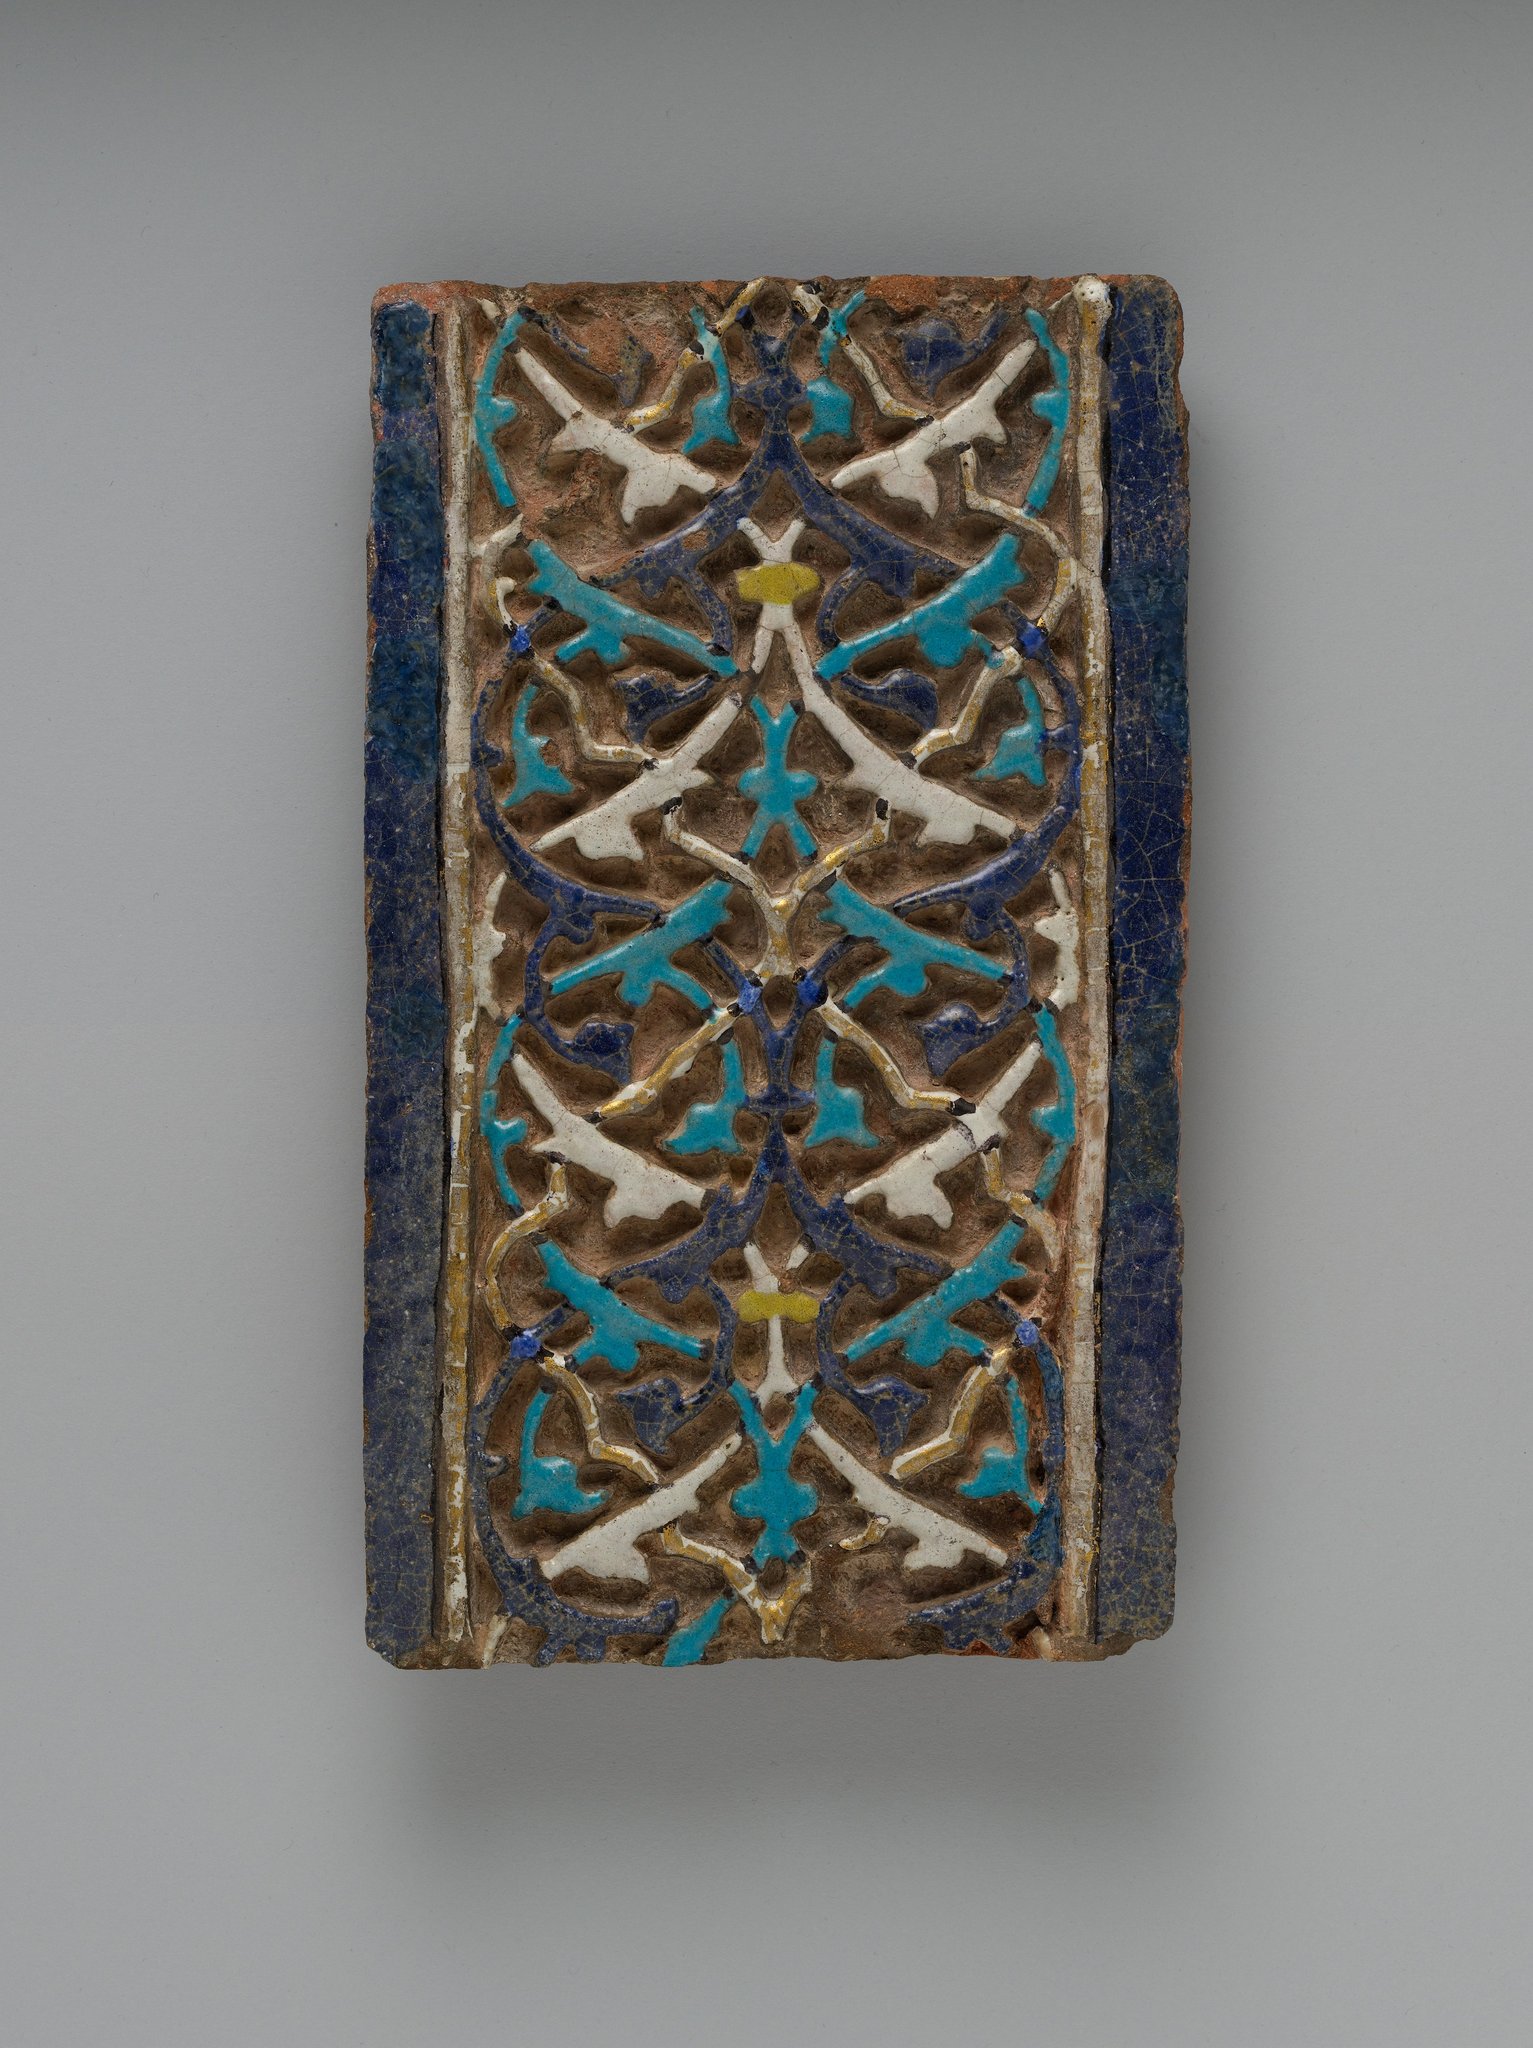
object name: tile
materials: earthenware, wax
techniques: gilding, glazing, molding, polychrome, resist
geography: turkey